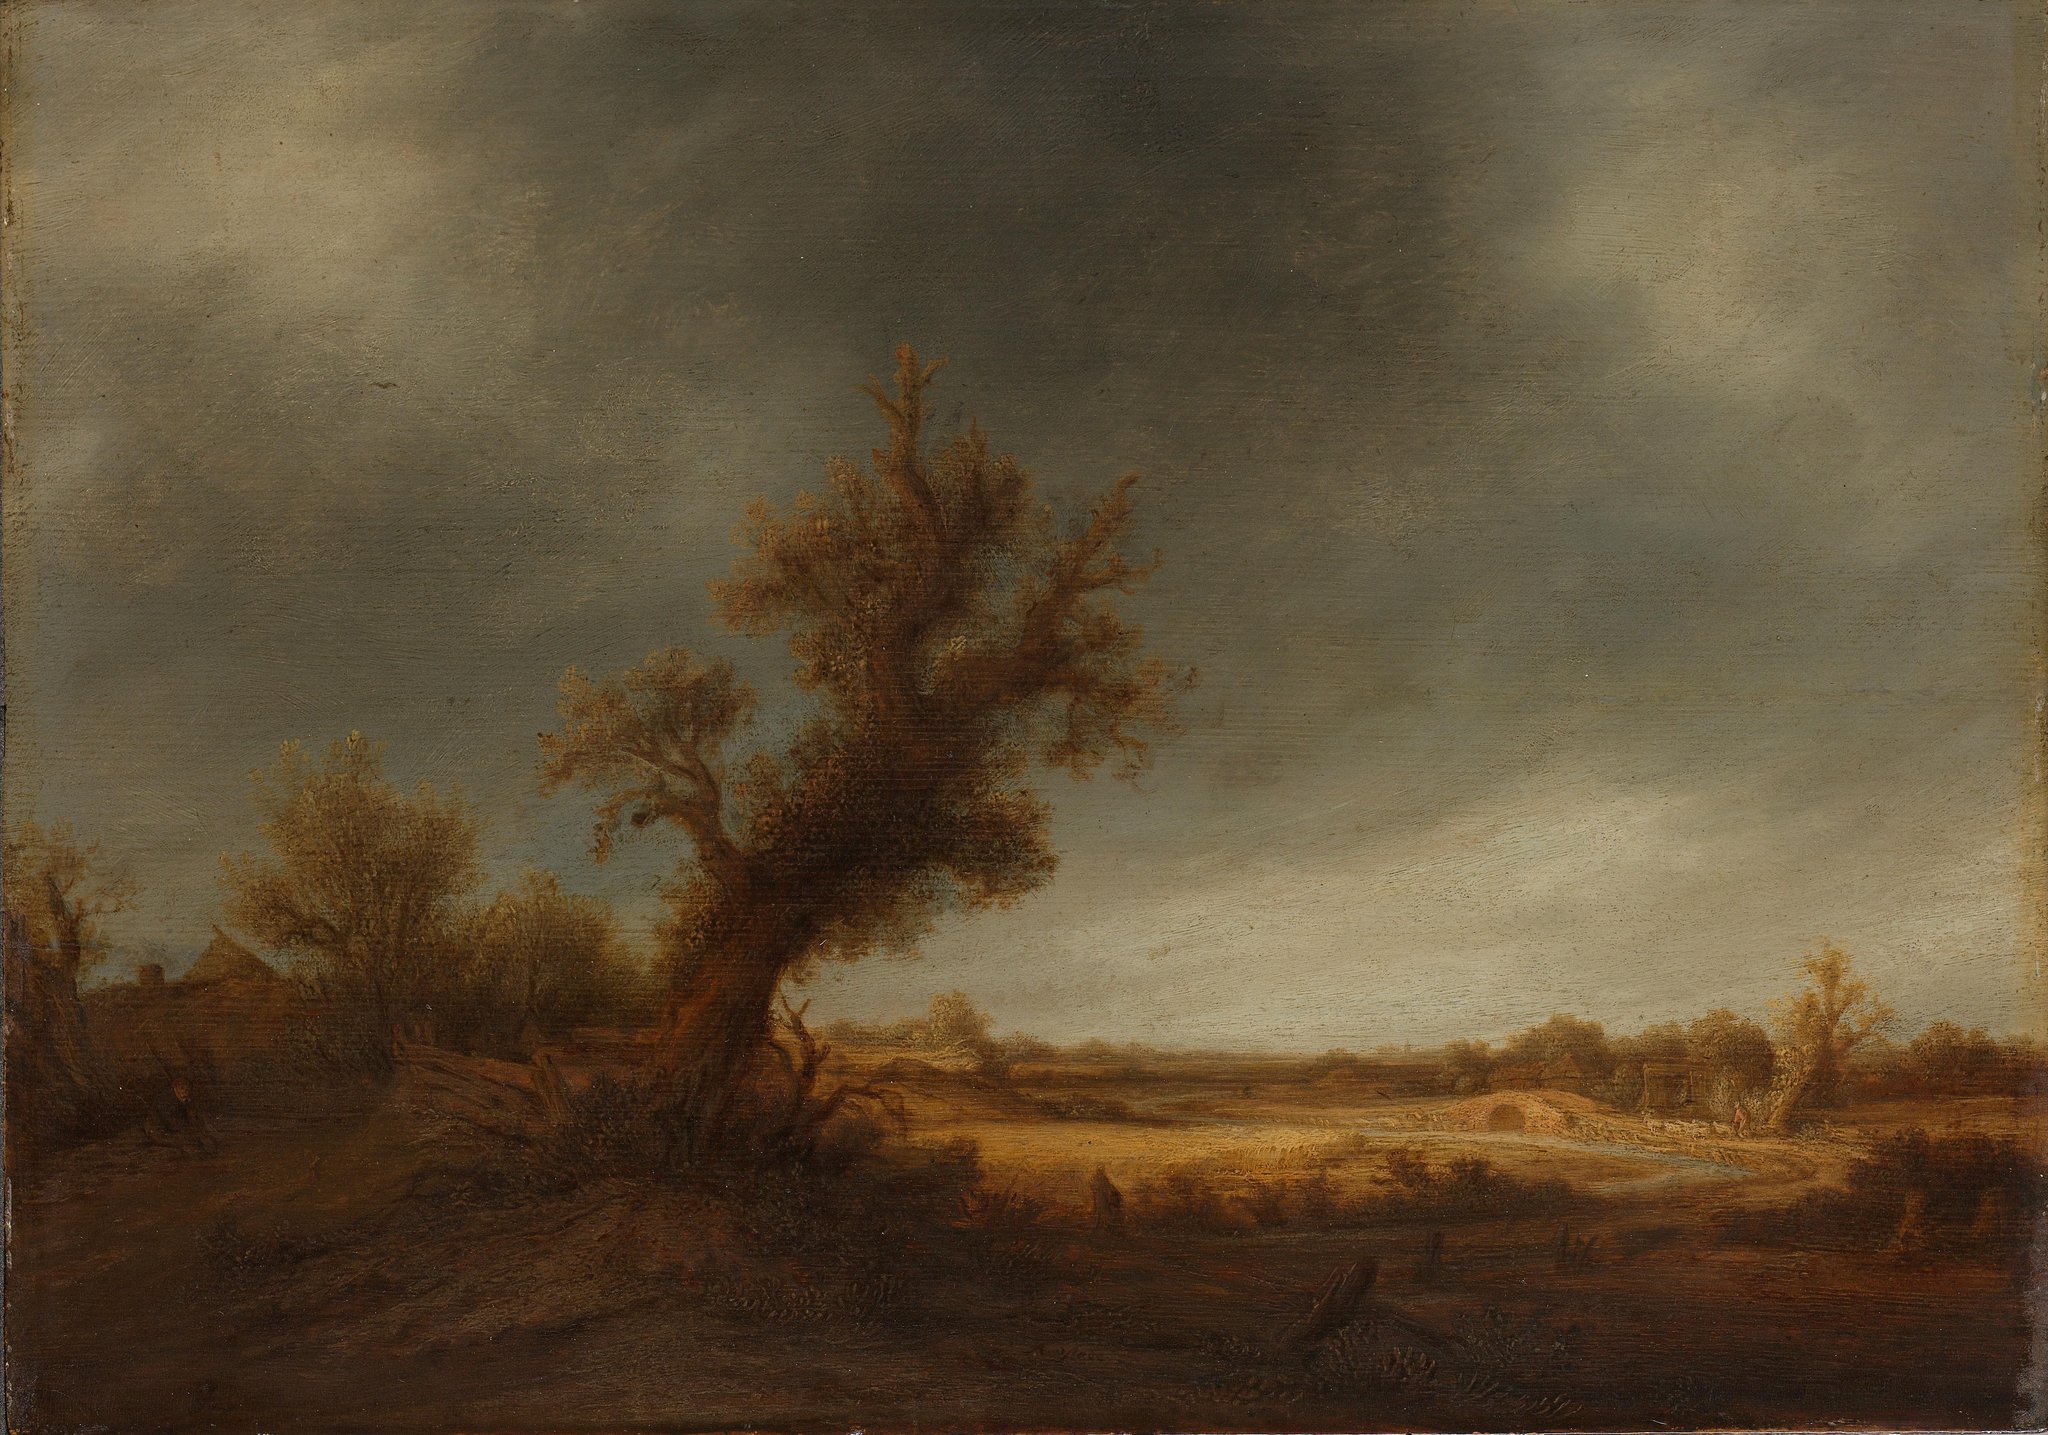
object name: painting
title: Landscape with an old Oak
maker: adriaen van ostade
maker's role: draughtsman, painter, print maker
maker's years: 1610-1685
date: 1639-1641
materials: oil, panel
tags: landscape with bridge, viaduct or aqueduct, dunes (sea not visible); in the dunes, trees: oak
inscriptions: signature, bottom centre: ‘A. ostade’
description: Adriaen van Ostade from Haarlem painted not only a great many genre scenes with farming folk, but also several landscapes. This painting, with its dramatic contrast between light and shadow, betrays the influence of Rembrandt.